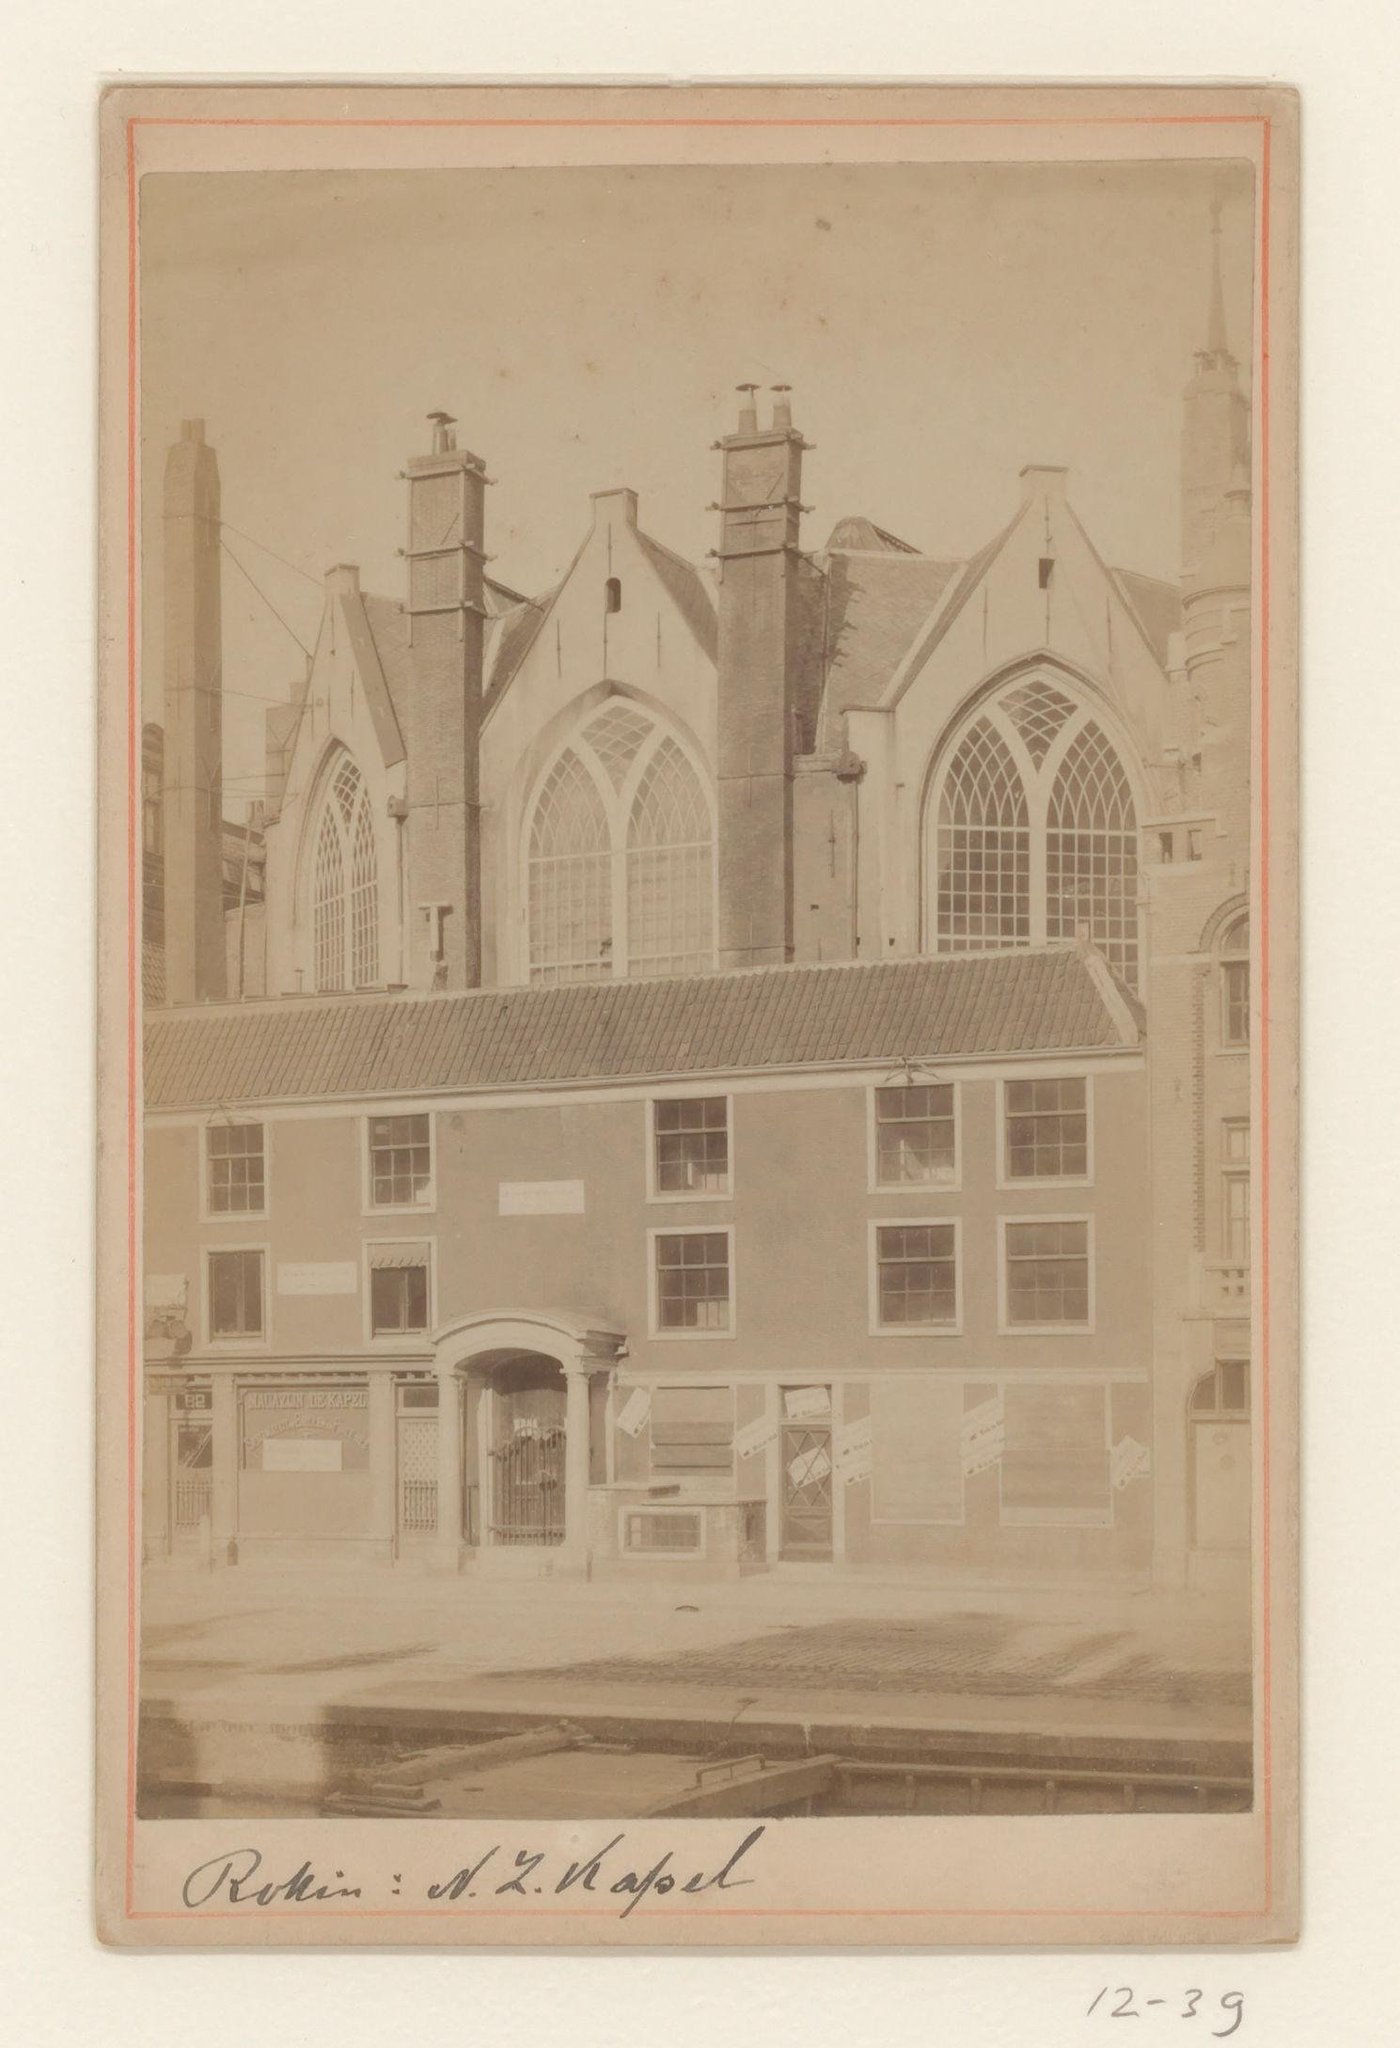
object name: cabinet photograph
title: Gezicht op de Nieuwezijds Kapel aan het Rokin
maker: Anonymous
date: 1912-1915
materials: cardboard, paper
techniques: albumen print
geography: amsterdam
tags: parts of church exterior and annexes: chapel - qq - small church, chapel, city-view in general; 'veduta', canal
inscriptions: inscription: ‘Rokin : N.Z. Kapel’, collector's mark: ‘12,39’ Lugt 1641b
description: Onderwerpsrubriek binnen de Atlas Amsterdam: Rokin, Rotterdammersloot, Rozengang, Rozengracht, Rozenstraat, Rusland, Rustenburgerstraat, Ruysdaelkade, Ruysdaelstraat, Ruyterkade (de), Ruyterweg (Admiraal de).